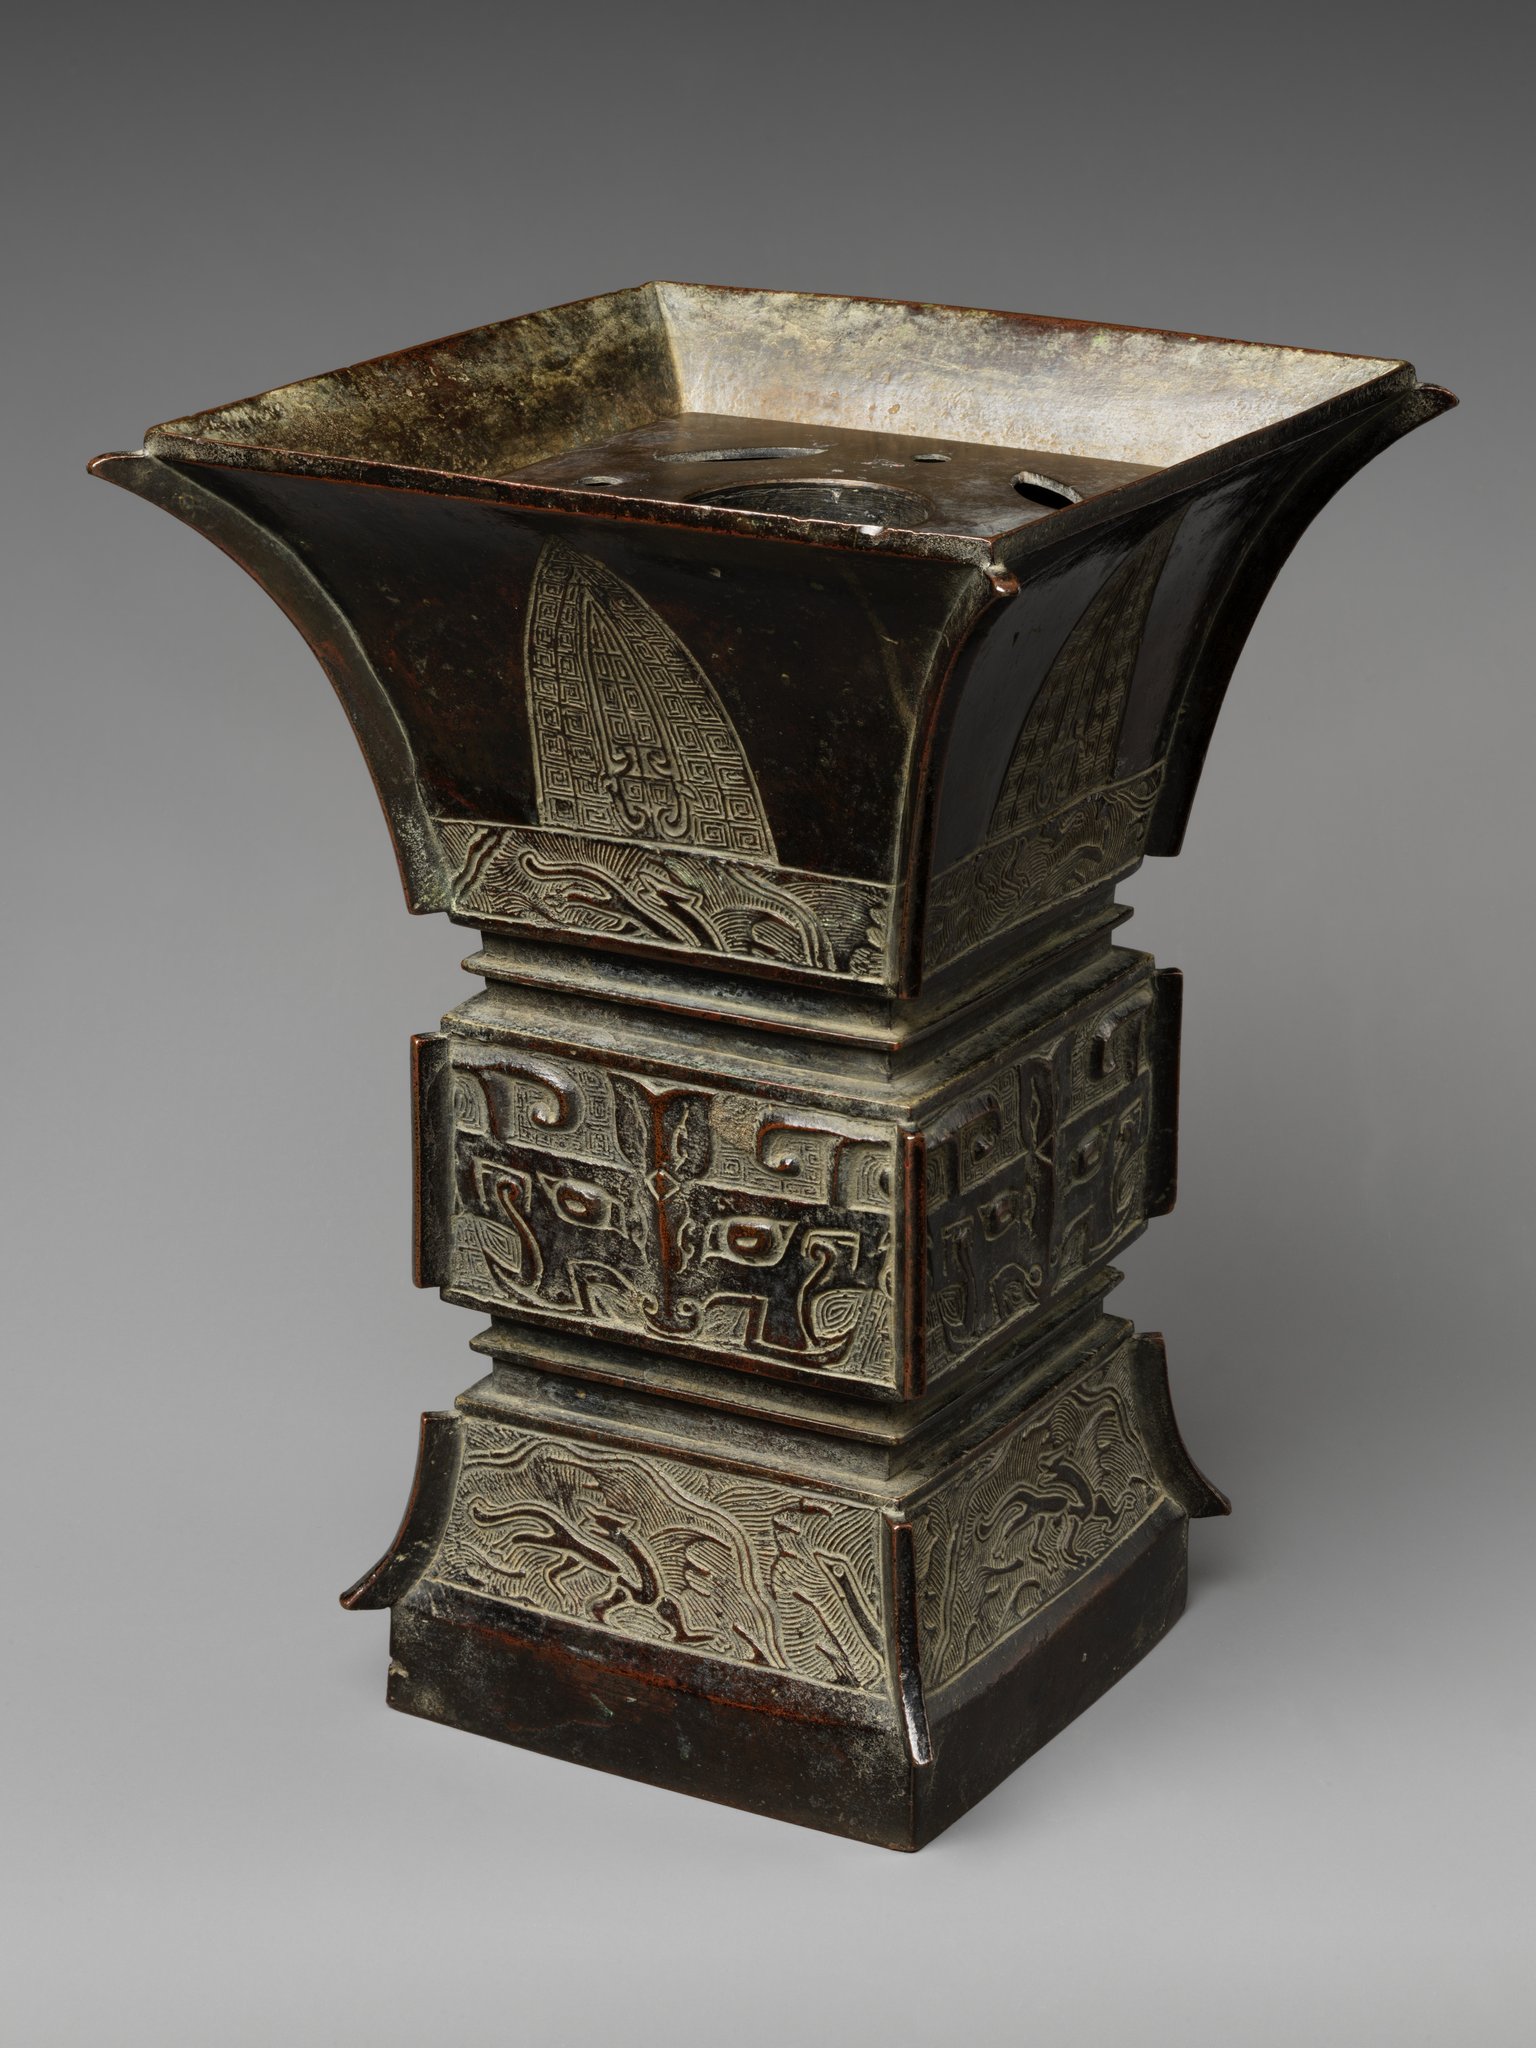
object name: vase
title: Square vase with archaic-style motifs (fangzun)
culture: chinese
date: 1301-1400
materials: copper alloy